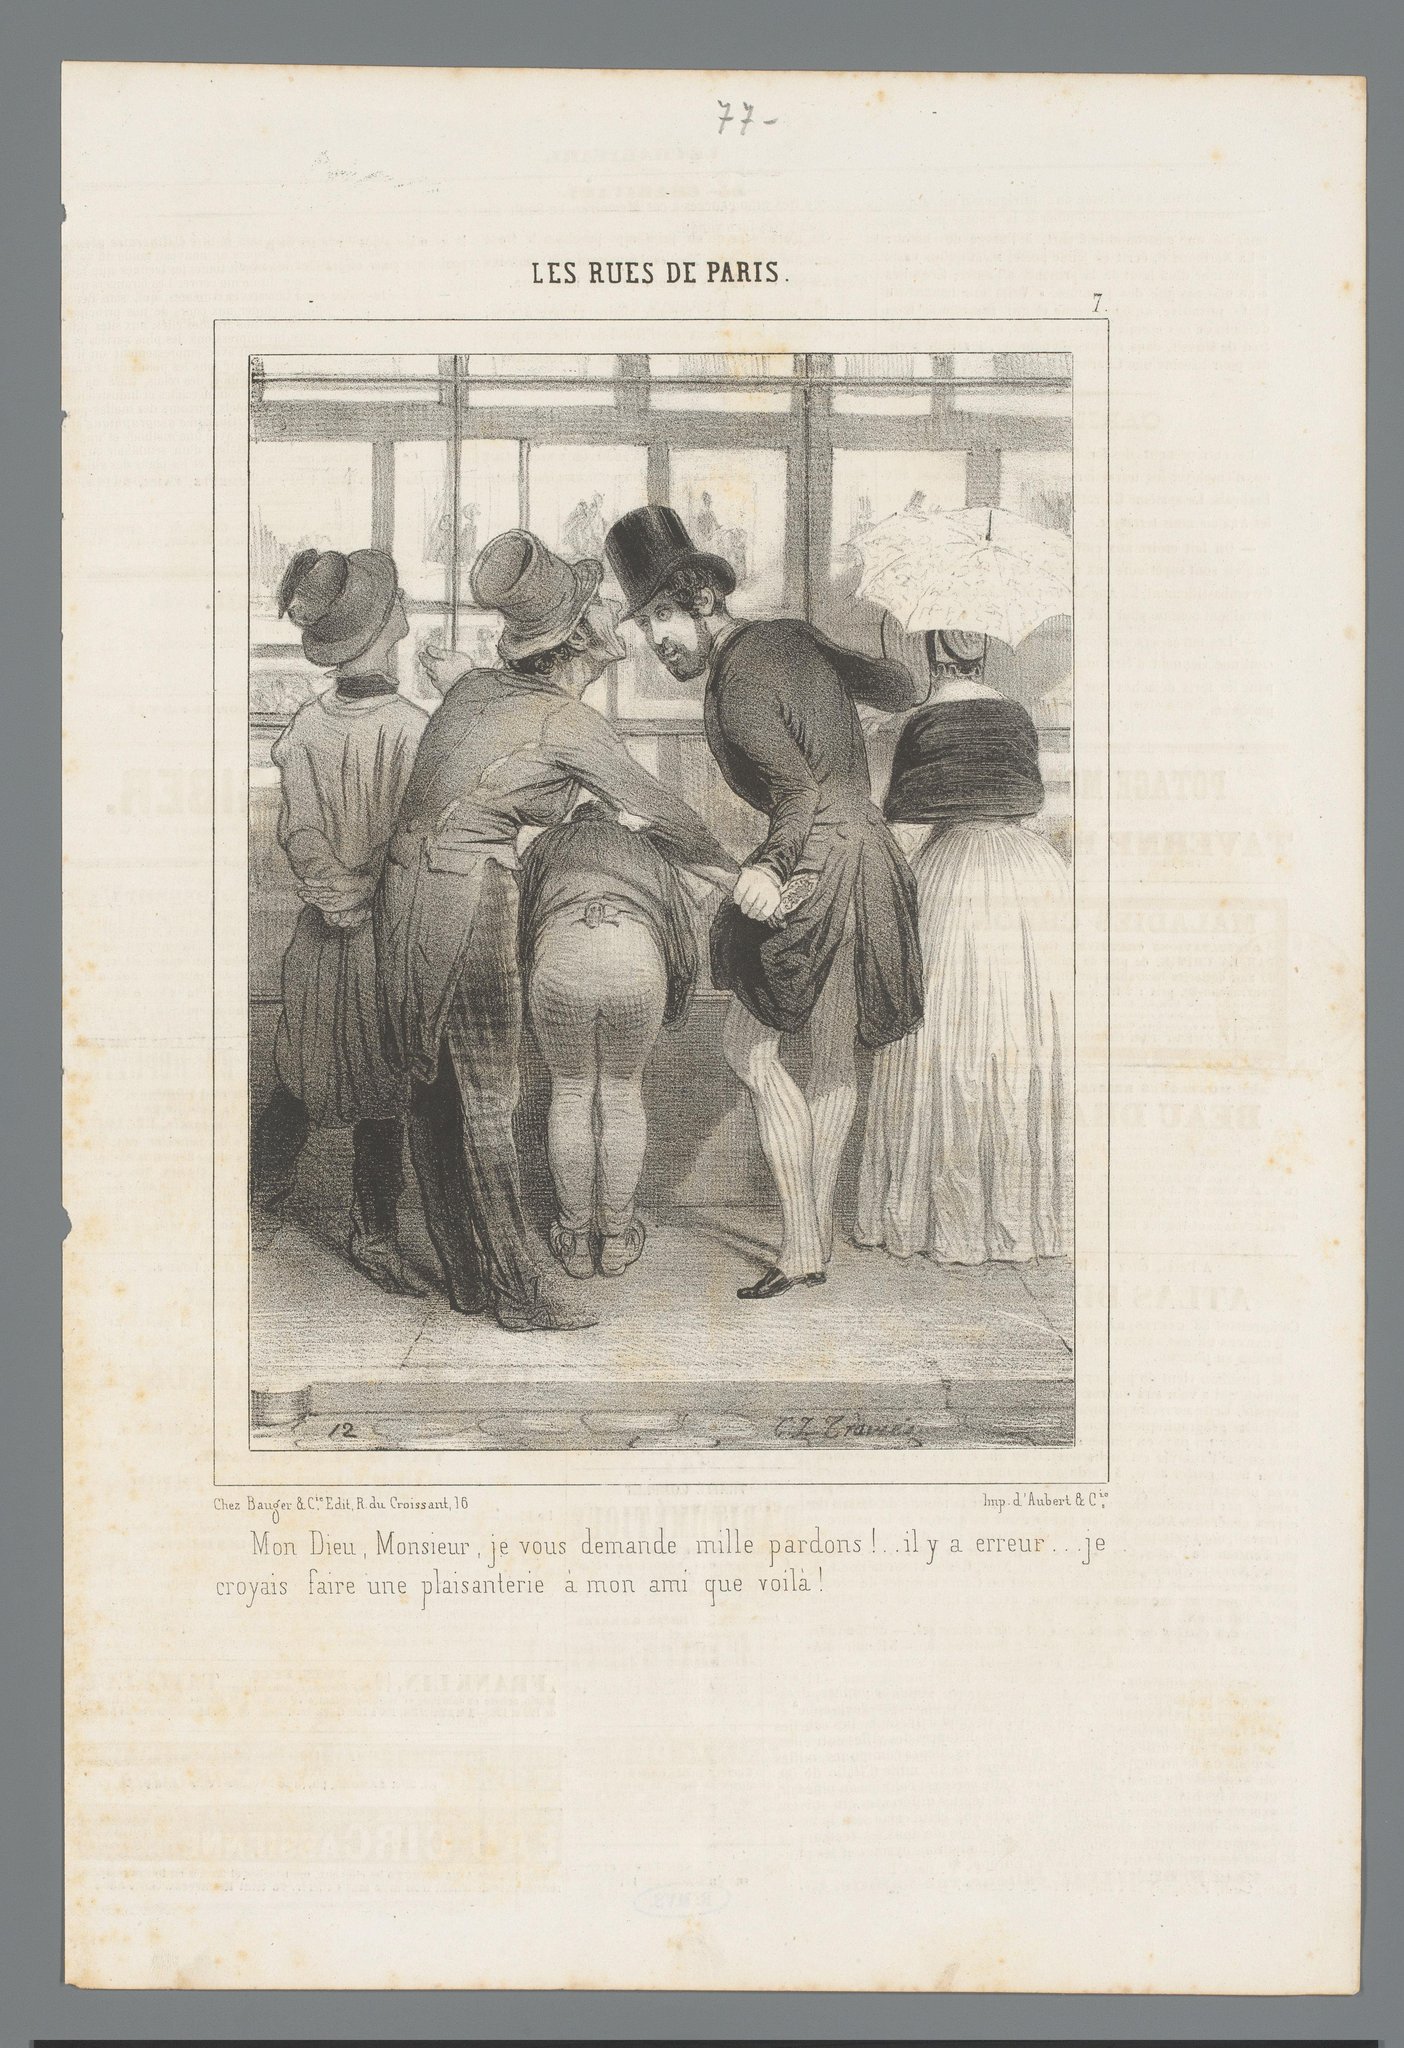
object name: cartoon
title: Mon Dieu, Monsieur, je vous demande (...)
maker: charles-joseph traviès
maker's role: print maker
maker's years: 1804-1859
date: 1842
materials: paper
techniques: letterpress printing, lithograph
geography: paris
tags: adult man ( + one person), pickpocket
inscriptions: collector's mark: Lugt 2228, stamp: ‘timbre royal’